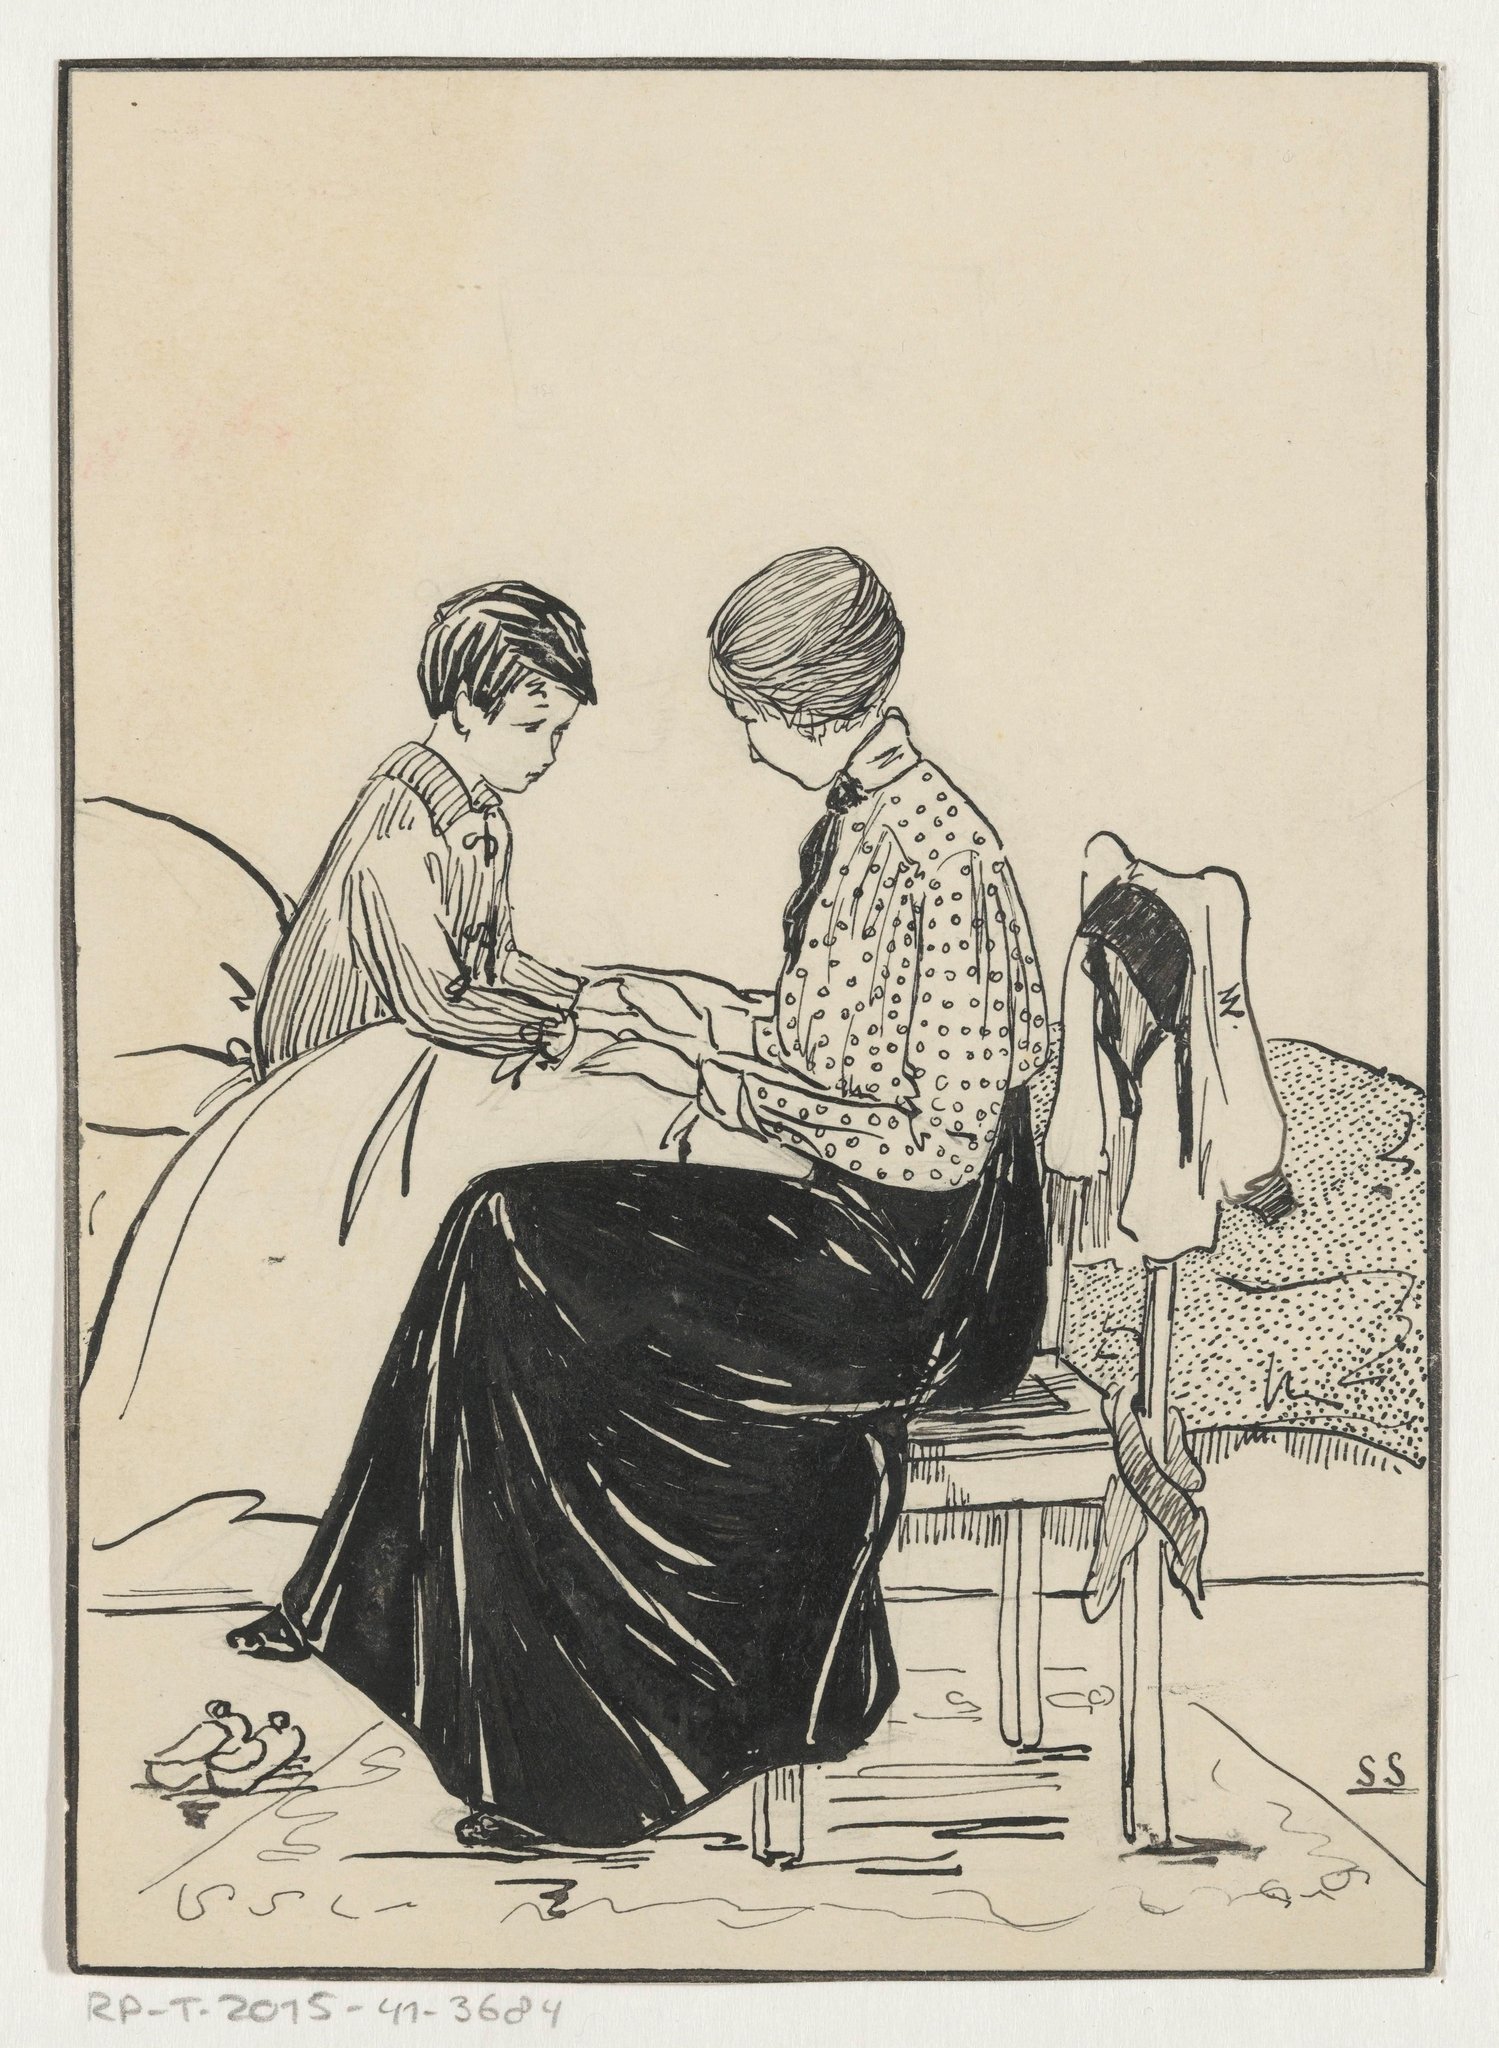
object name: boekillustratie ontwerp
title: Vrouw aan het bed van een jongen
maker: Anonymous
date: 1880-1930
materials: cardboard, ink, pencil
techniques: brush, pen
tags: bed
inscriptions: collector's mark: Lugt 2228a, signature: ‘SS’, annotation: ‘Jan’, :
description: Een jongen zit rechtop in bed. Naast het bed zit een vrouw op een stoel. Zij houdt de handen van de jongen vast.